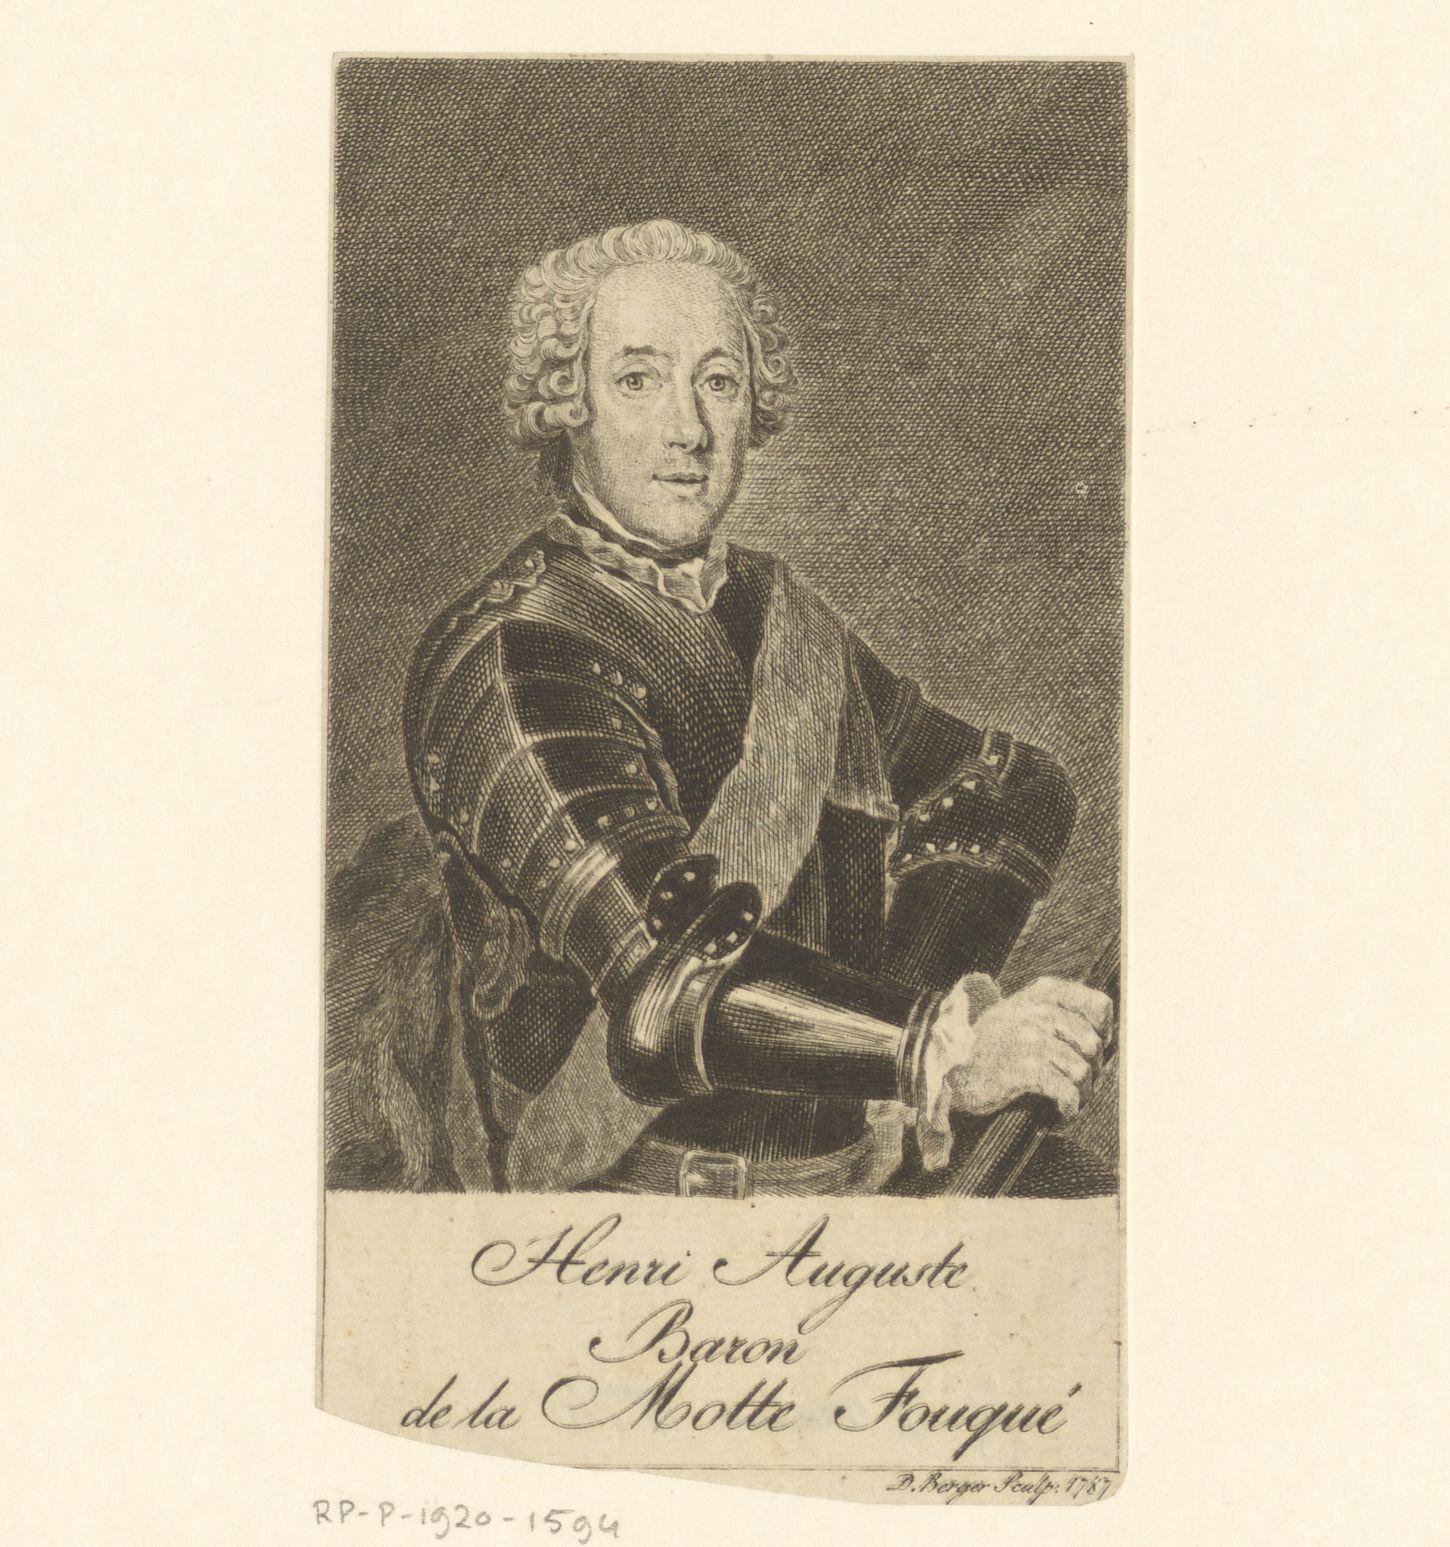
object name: print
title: Portret van Heinrich August de la Motte Fouqué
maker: daniel berger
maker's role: print maker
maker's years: 1744-1824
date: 1787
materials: paper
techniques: engraving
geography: berlin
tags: the hague, historical persons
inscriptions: collector's mark: Lugt 2228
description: Prent ook gebruikt in: Motte Fouqué, Heinrich August de la. Mémoires. 2 dln. Berlijn: François De LaGarde, 1788.